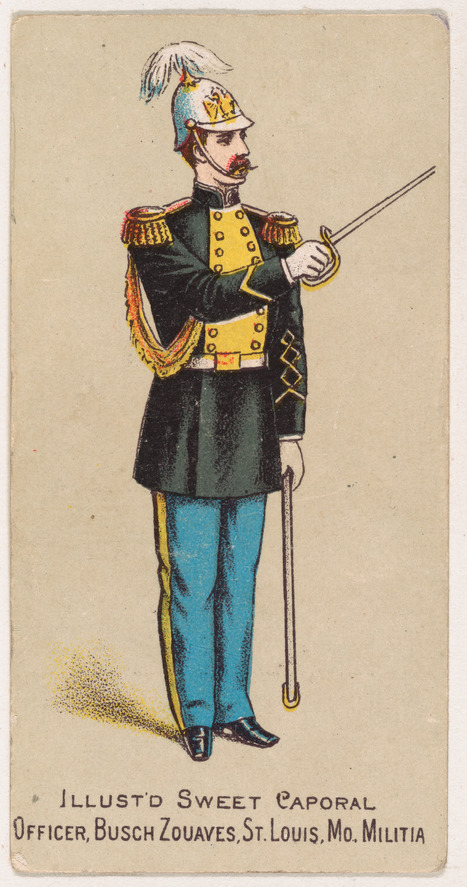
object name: print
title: Officer, Busch Zouaves, St. Louis, Missouri Militia, from the Military Series (N224) issued by Kinney Tobacco Company to promote Sweet Caporal Cigarettes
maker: kinney brothers tobacco company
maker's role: publisher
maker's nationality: american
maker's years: 1869-2011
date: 1888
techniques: color lithograph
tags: military,men